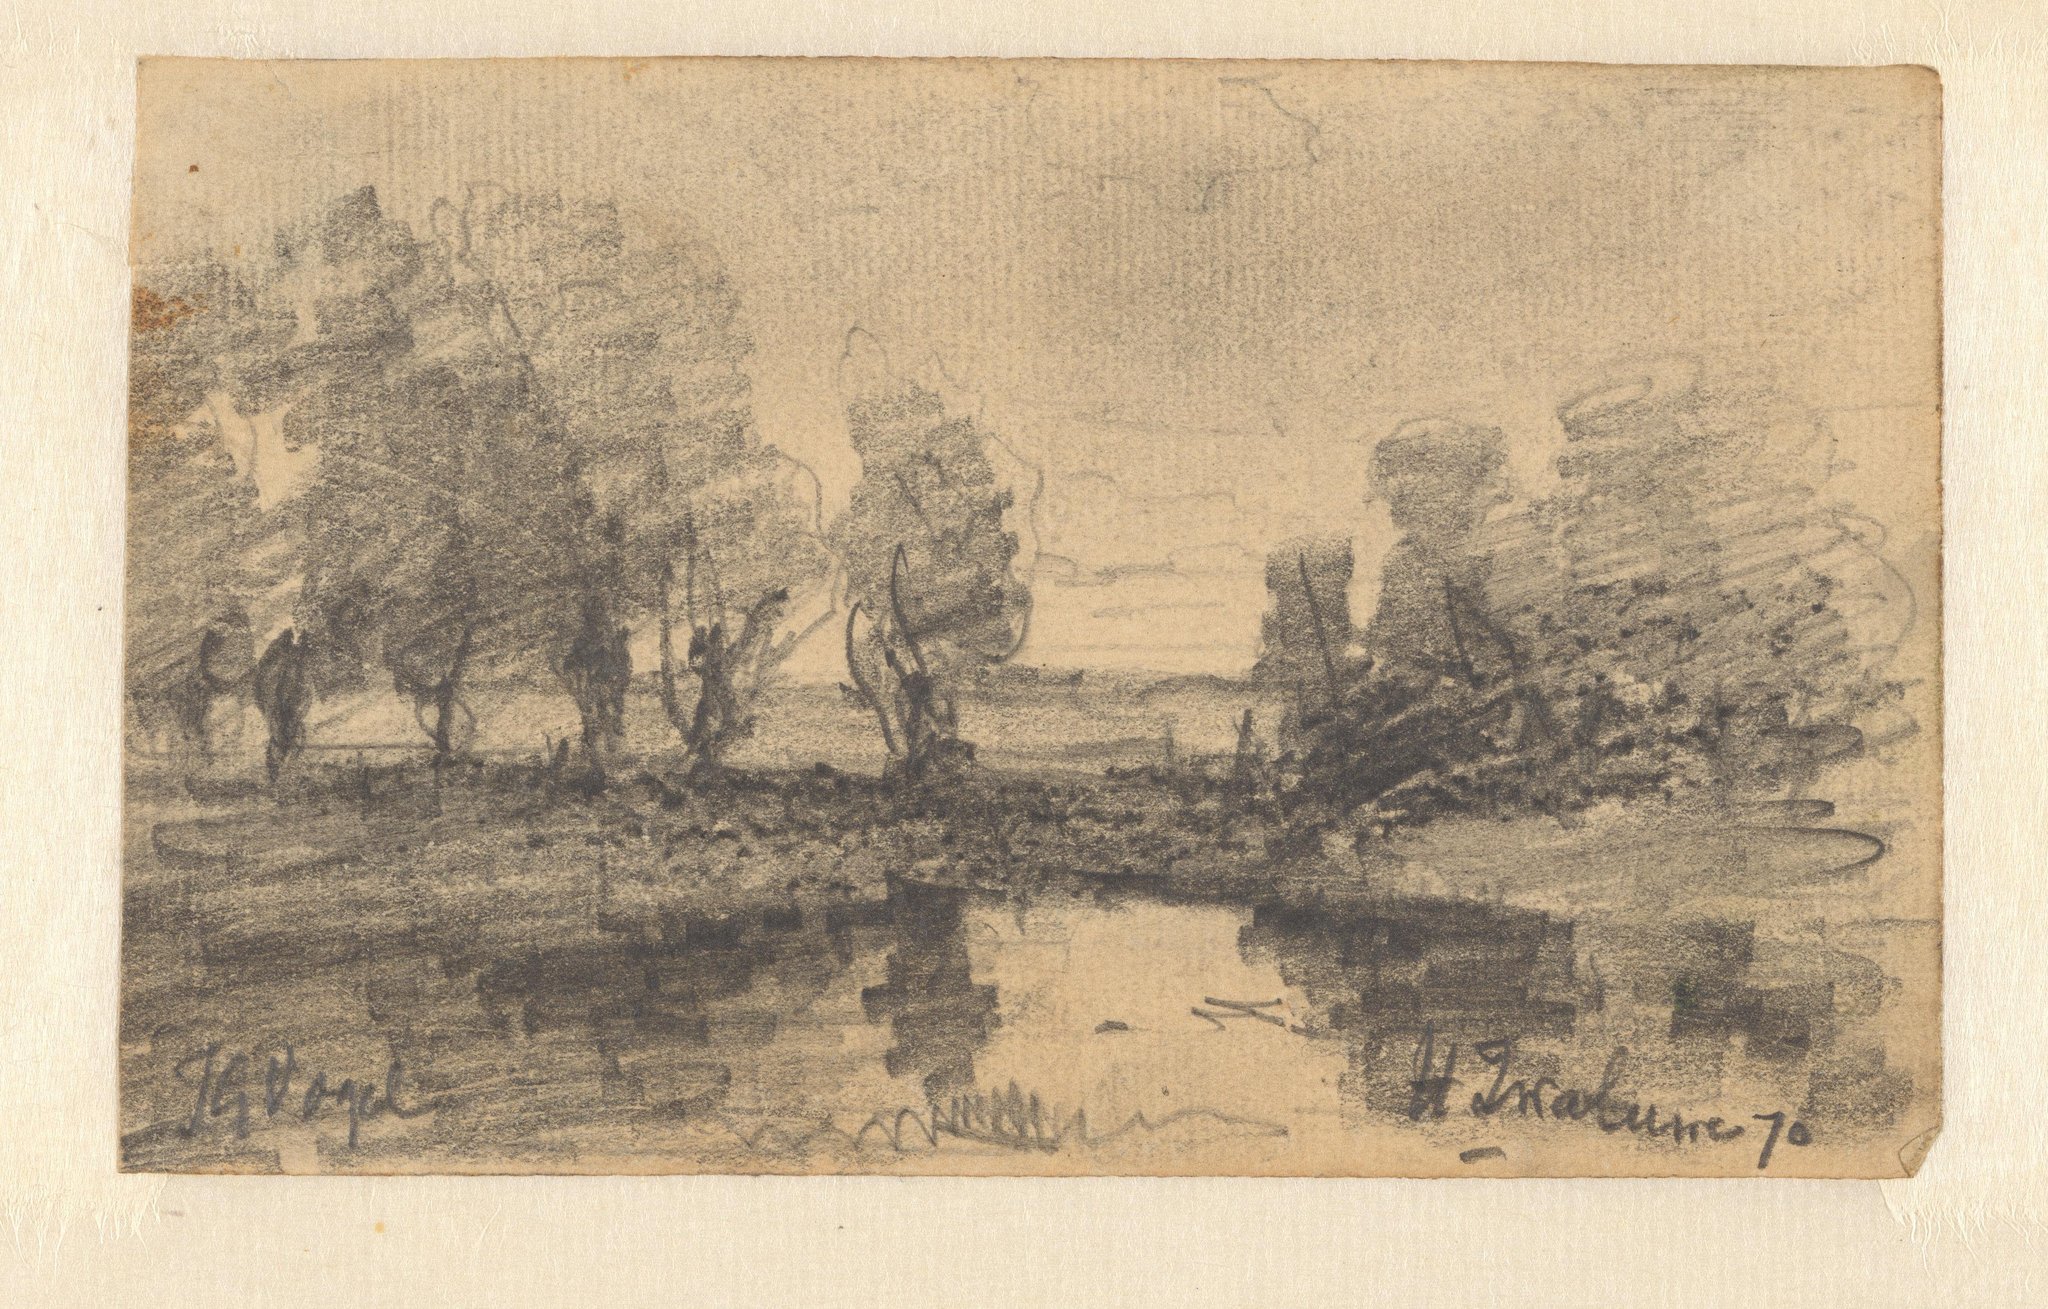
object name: drawing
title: Bomen langs een waterkant bij Hooge Zwaluwe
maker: johannes gijsbert vogel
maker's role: draughtsman, painter, print maker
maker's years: 1828-1915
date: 1870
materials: paper, pencil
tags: trees, landscapes with waters, waterscapes, seascapes (in the temperate zone)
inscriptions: date and inscription: ‘H Zwaluwe 70’, collector's mark: Lugt 1181b